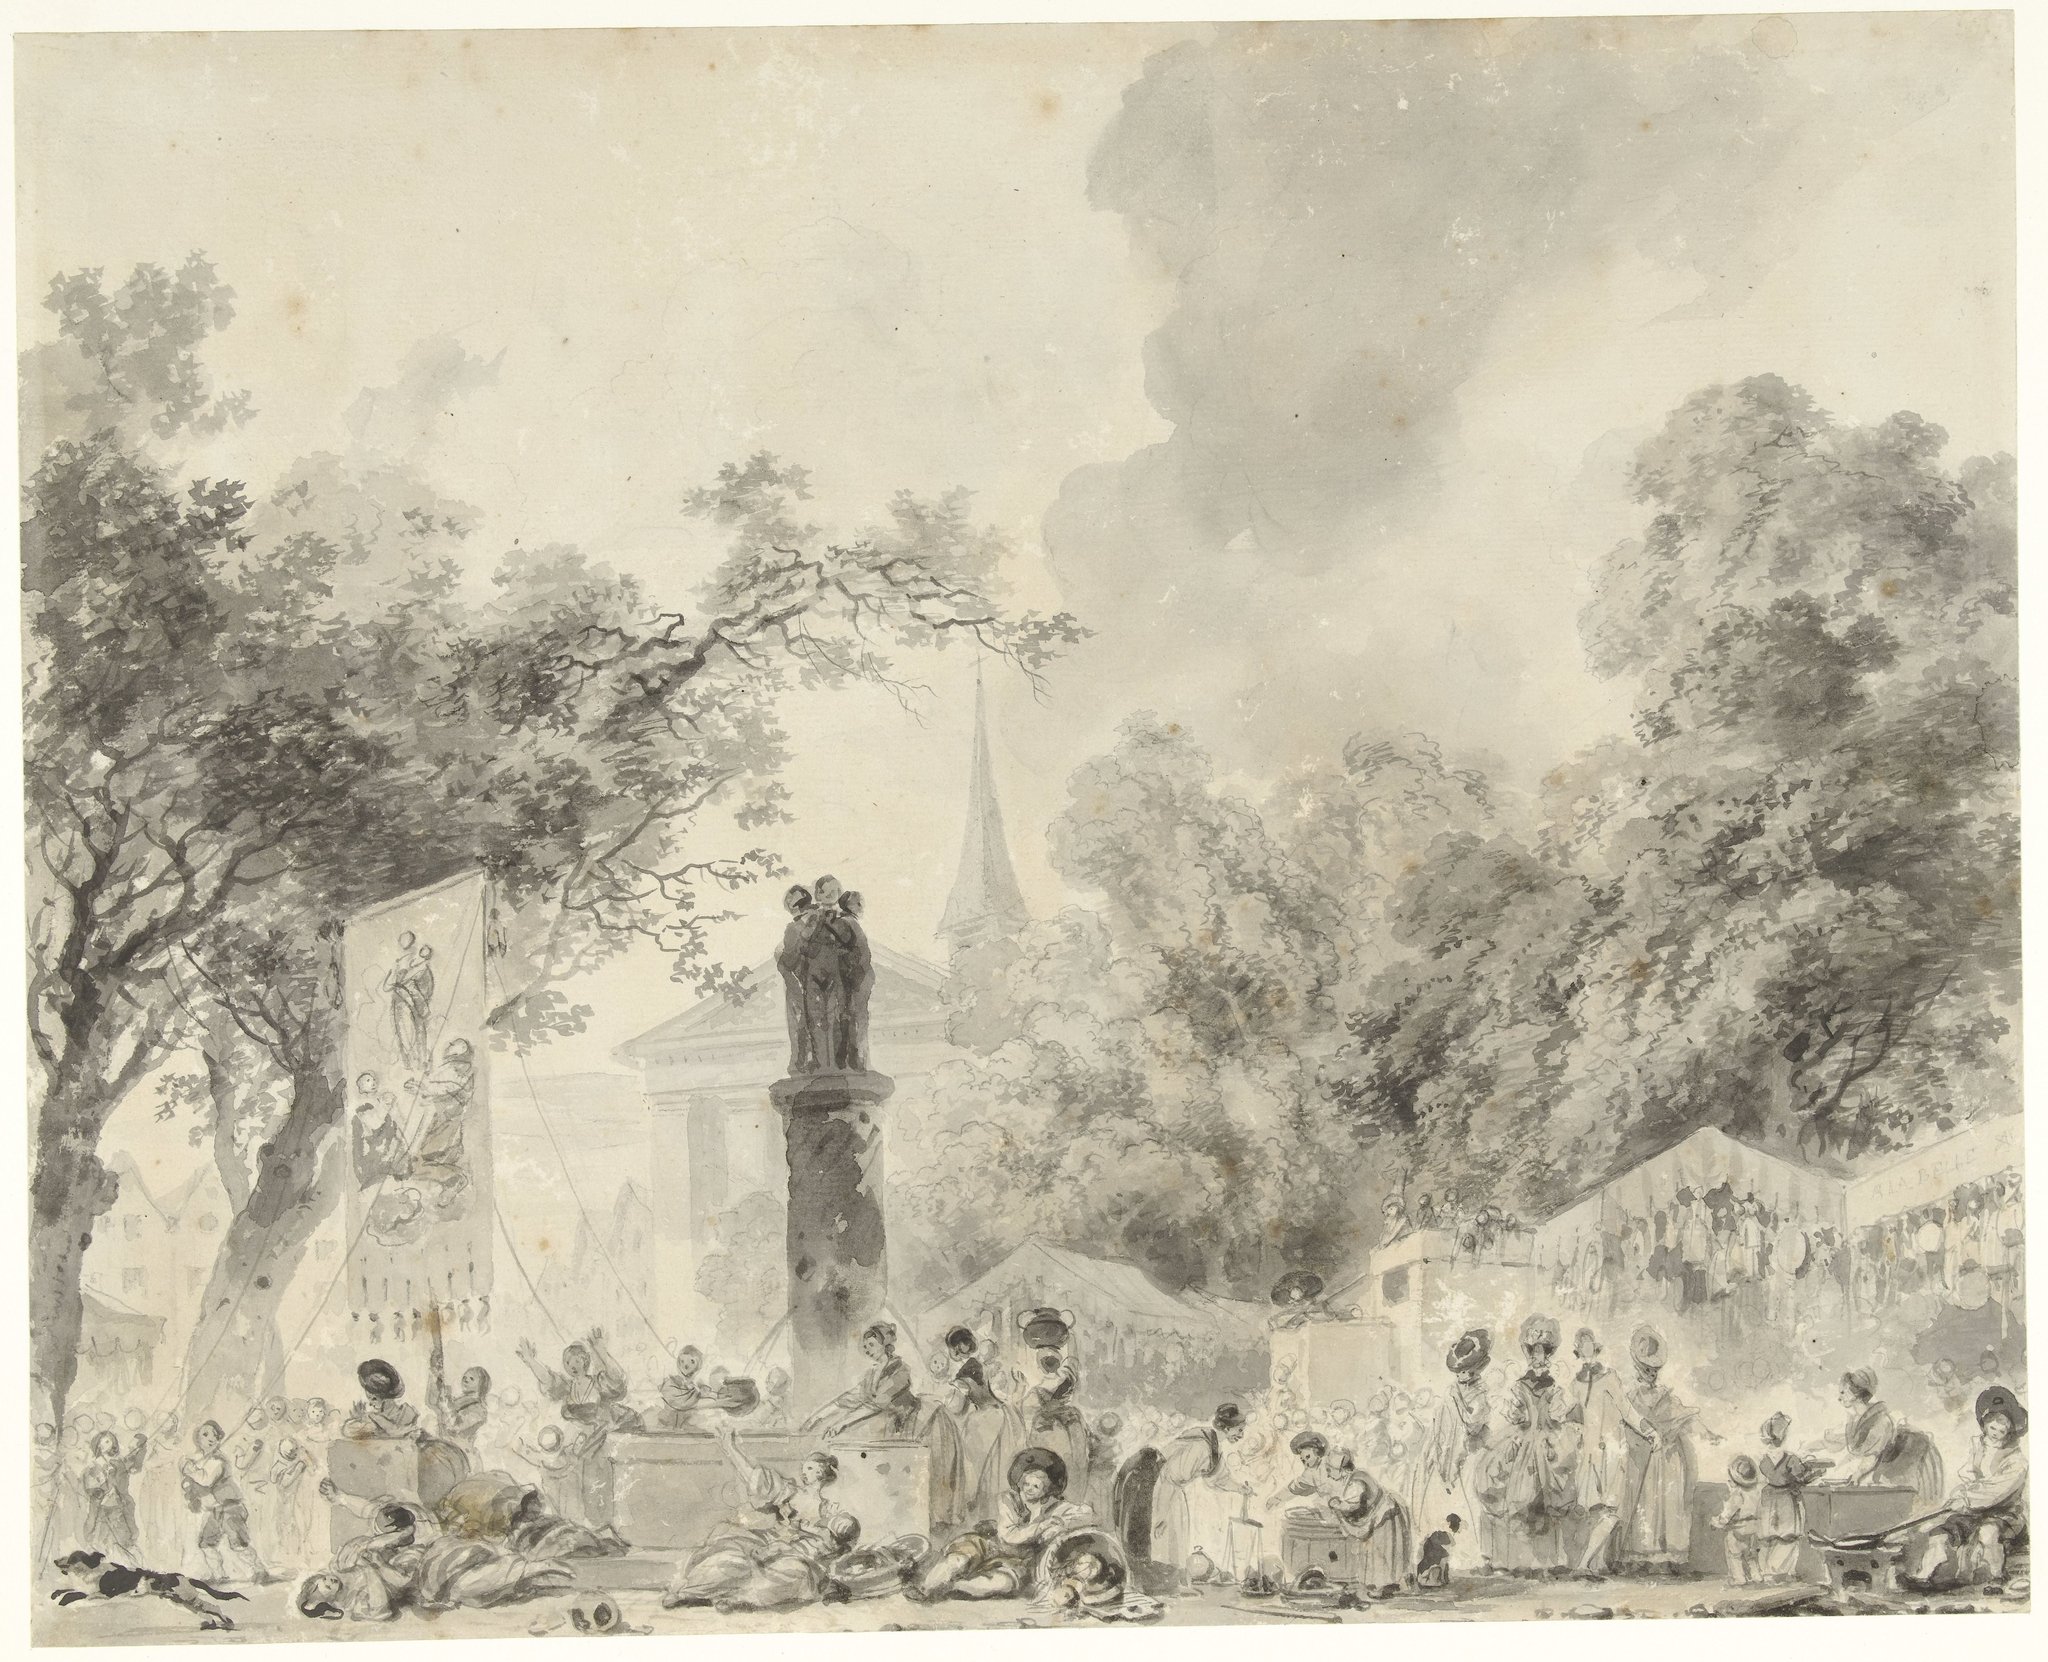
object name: drawing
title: Een feestdag in de stad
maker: jean honoré fragonard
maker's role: draughtsman, painter, print maker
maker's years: 1732-1806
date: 1775-1780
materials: graphite, paper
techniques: brush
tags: open-air recreation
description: Geassocieerd met de jaarlijkse feestkermis te St. Cloud, maar uit de tekening blijkt geen topografische intentie (R.J. te Rijdt).